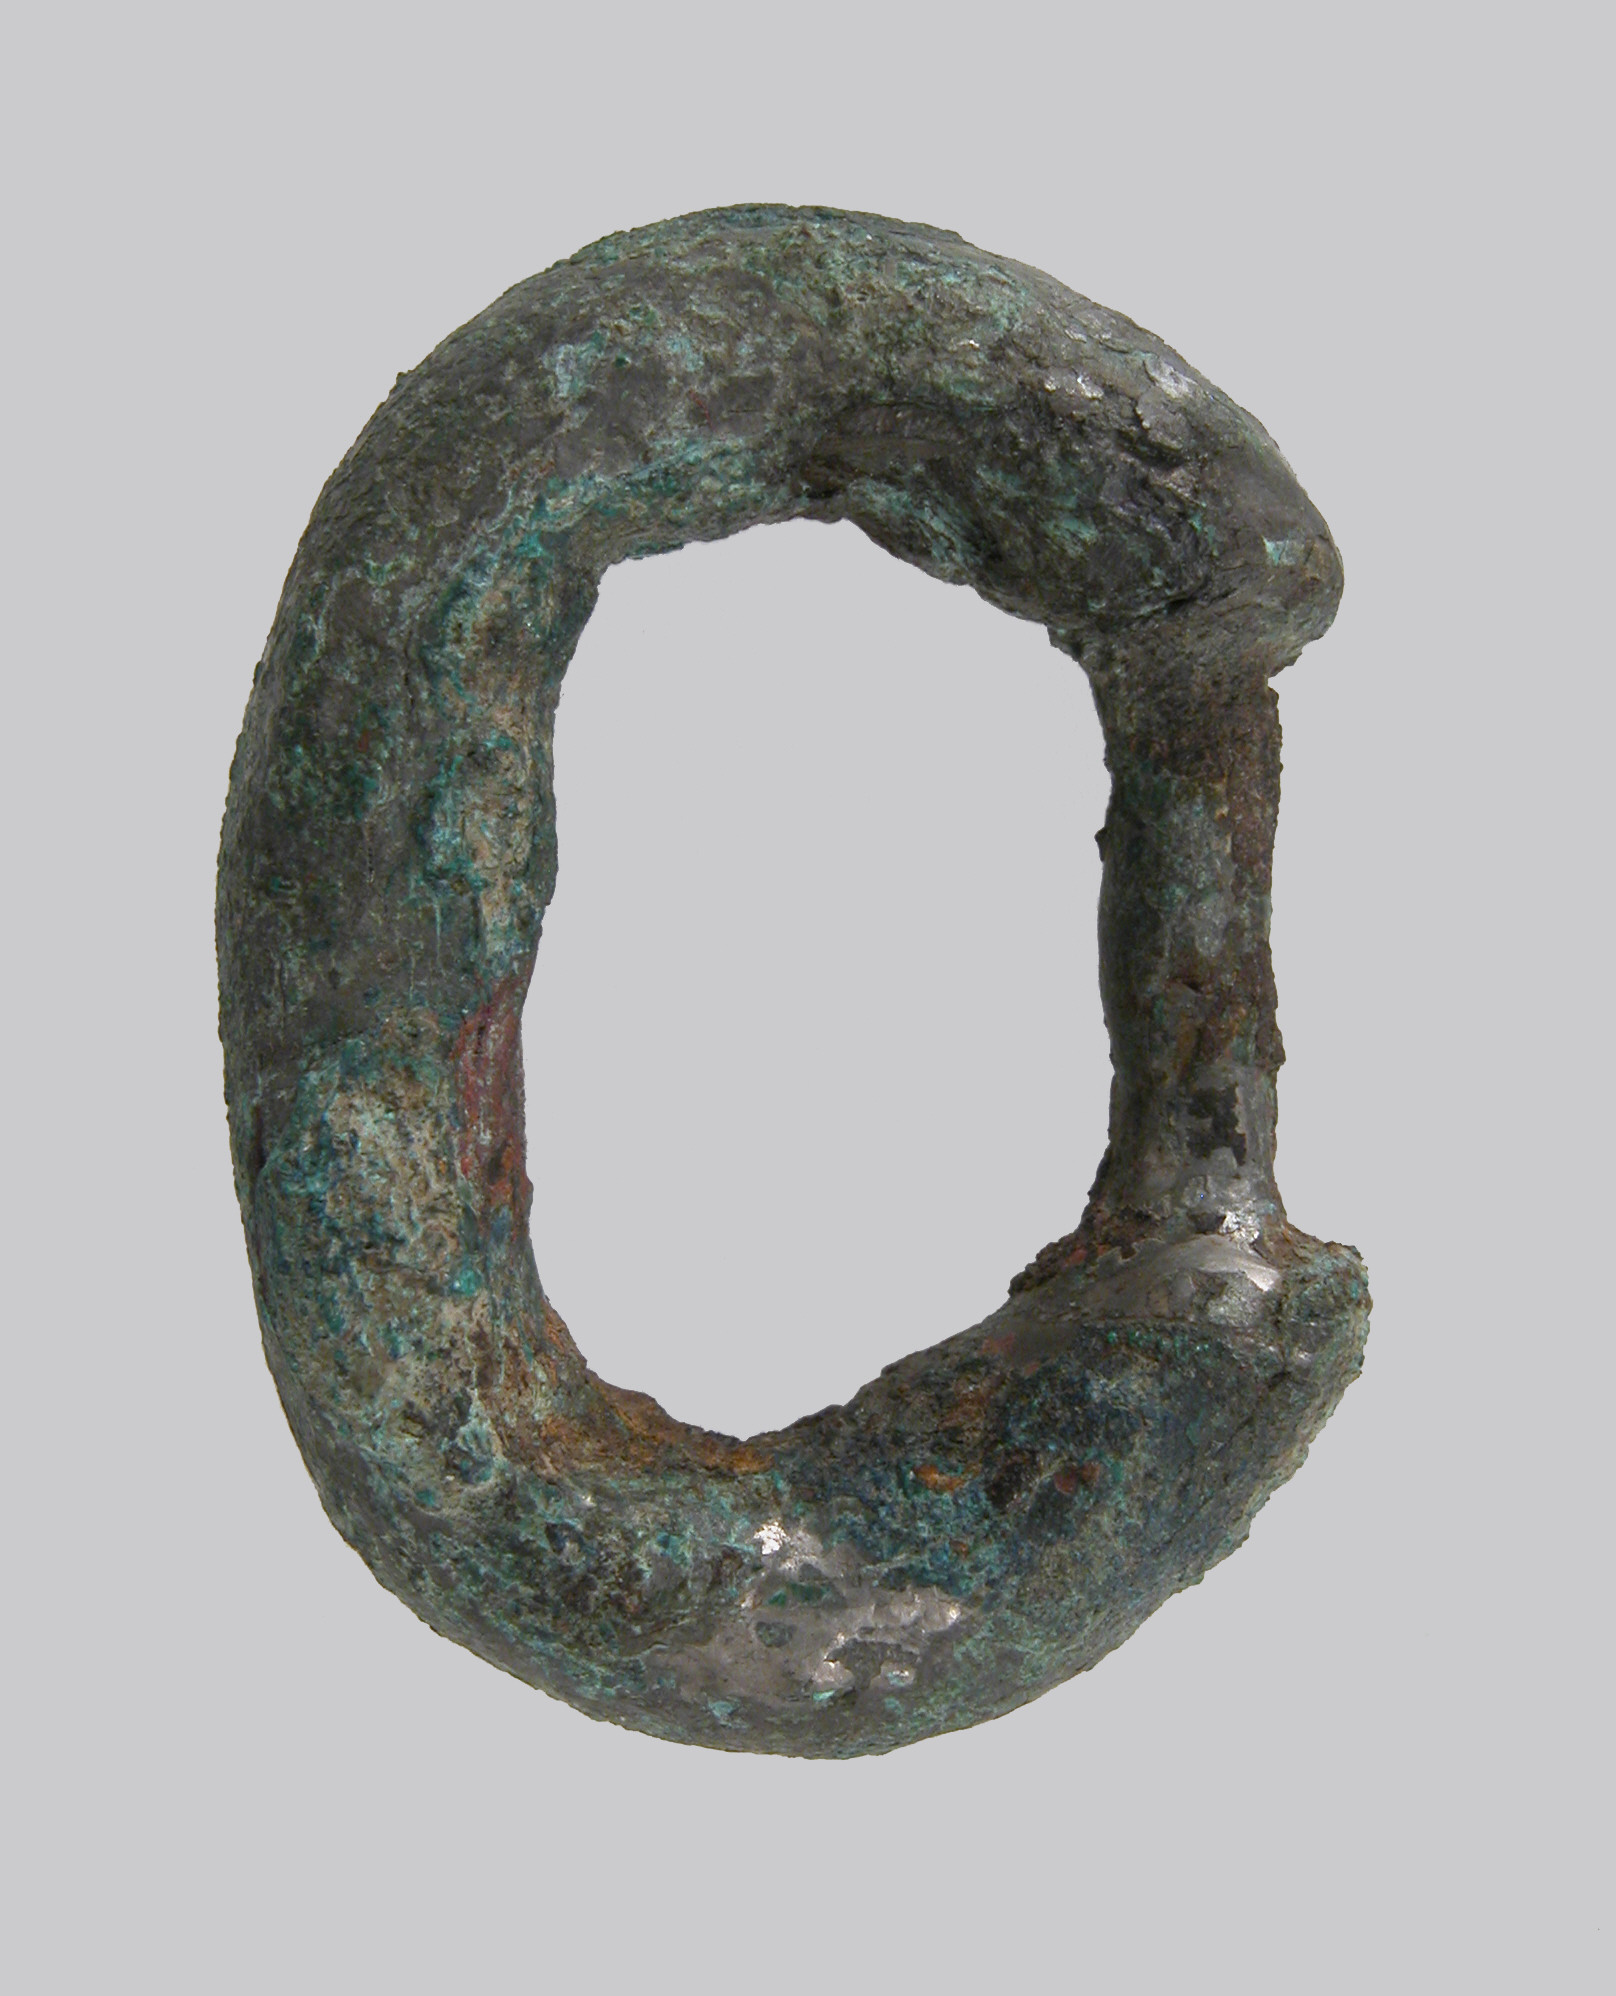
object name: loop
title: Buckle Loop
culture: frankish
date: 500-700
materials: copper alloy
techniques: silvered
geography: germany